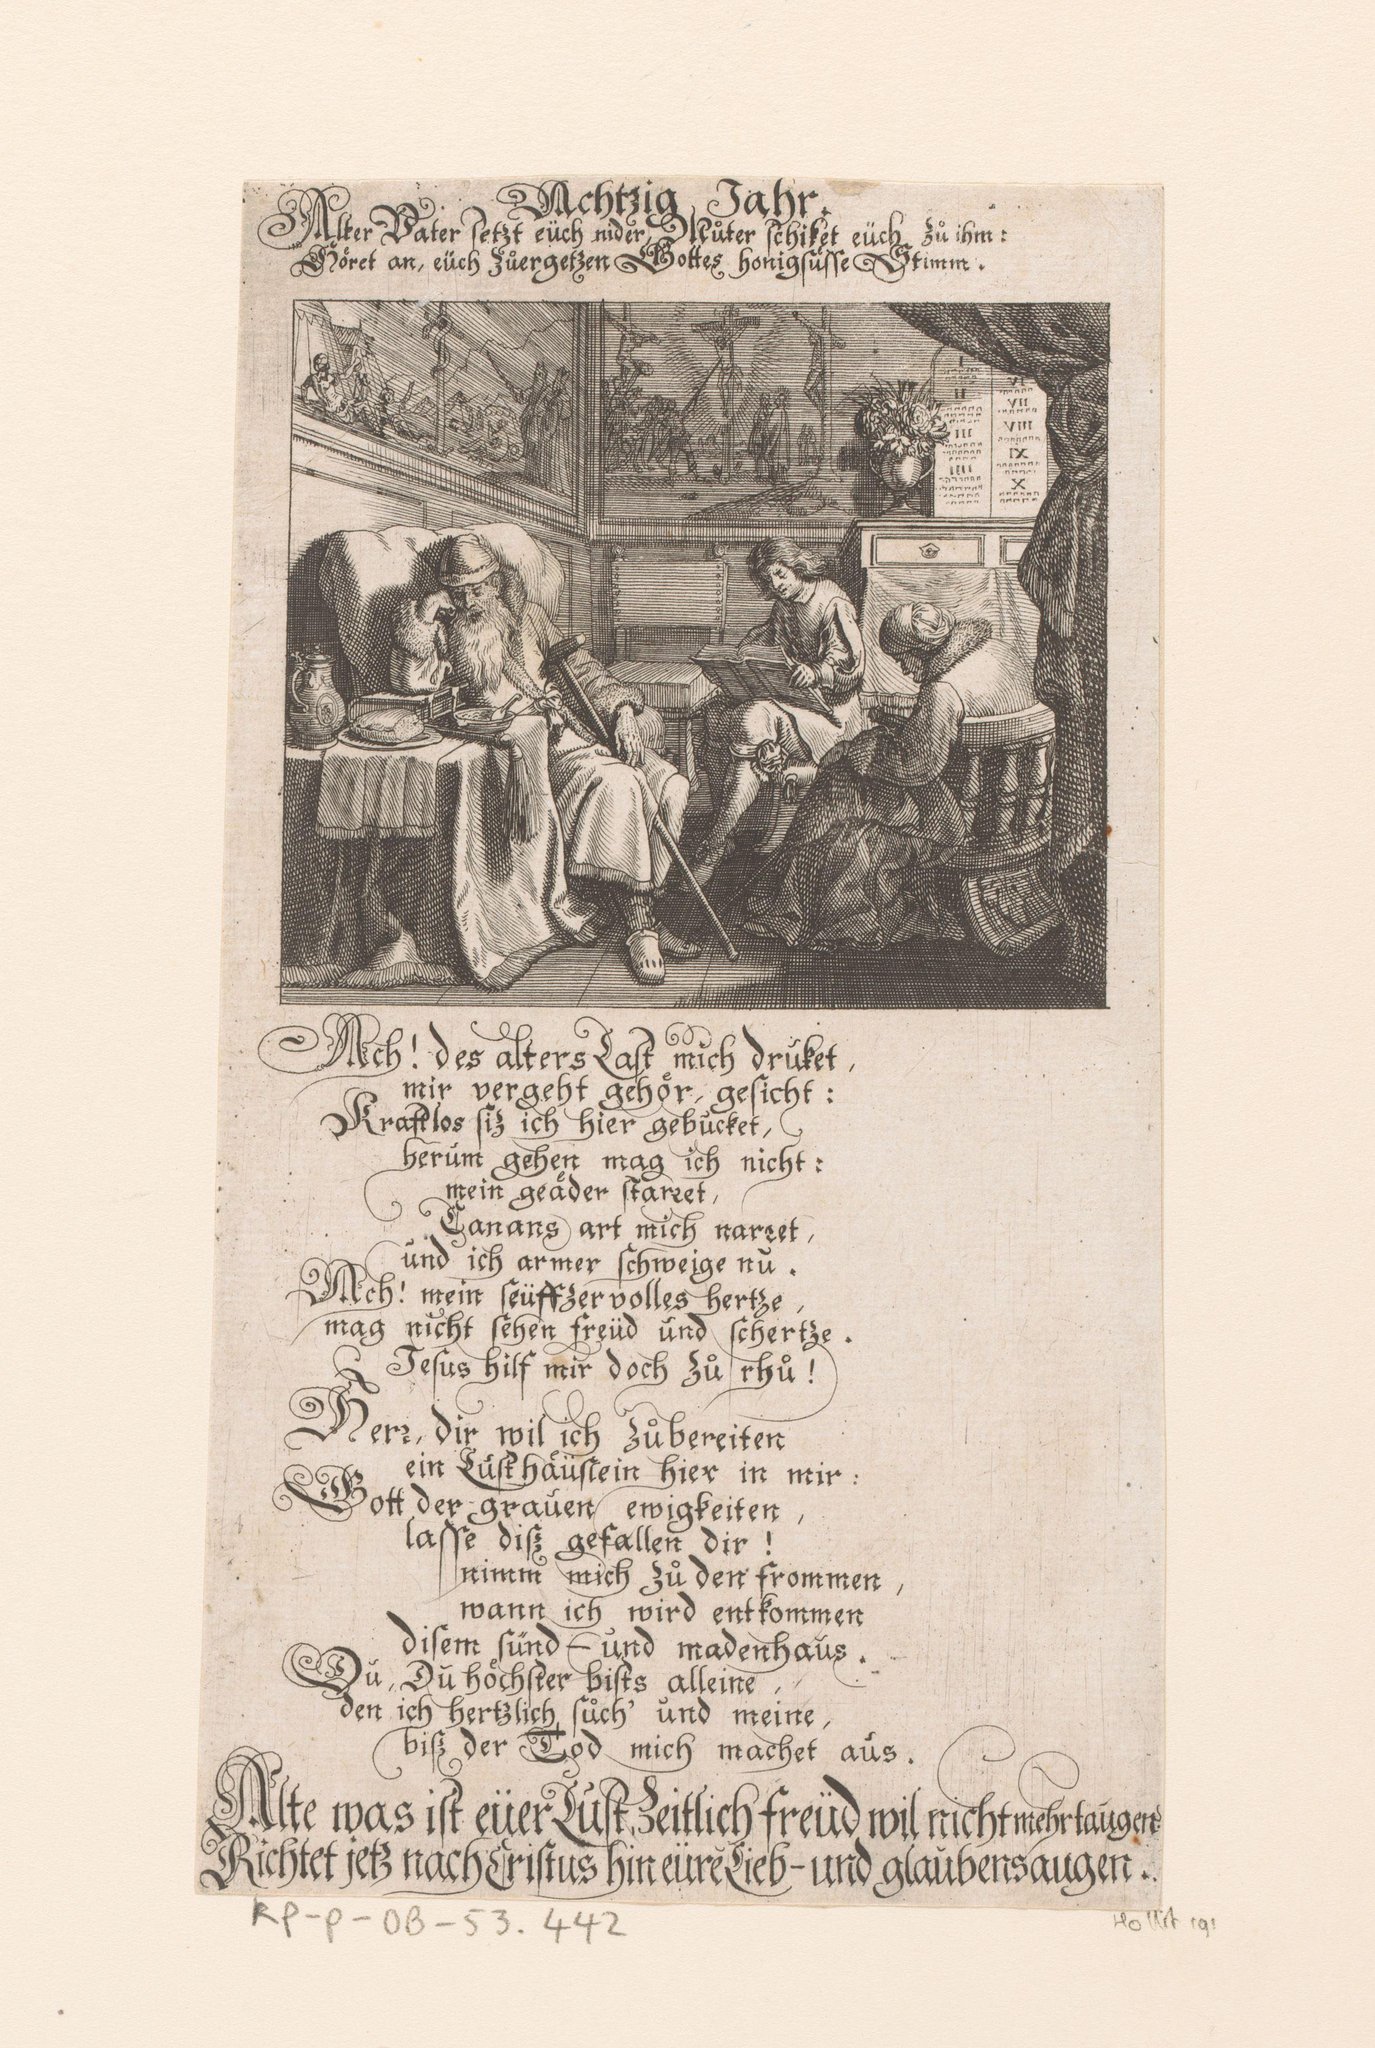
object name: print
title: Achtzig Jahr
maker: conrad meyer (i)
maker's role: painter, print maker, publisher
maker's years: 1618-1689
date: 1675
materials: paper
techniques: etching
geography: zurich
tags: sleeping in chair, human life and its ages (young, adult, old, etc.)